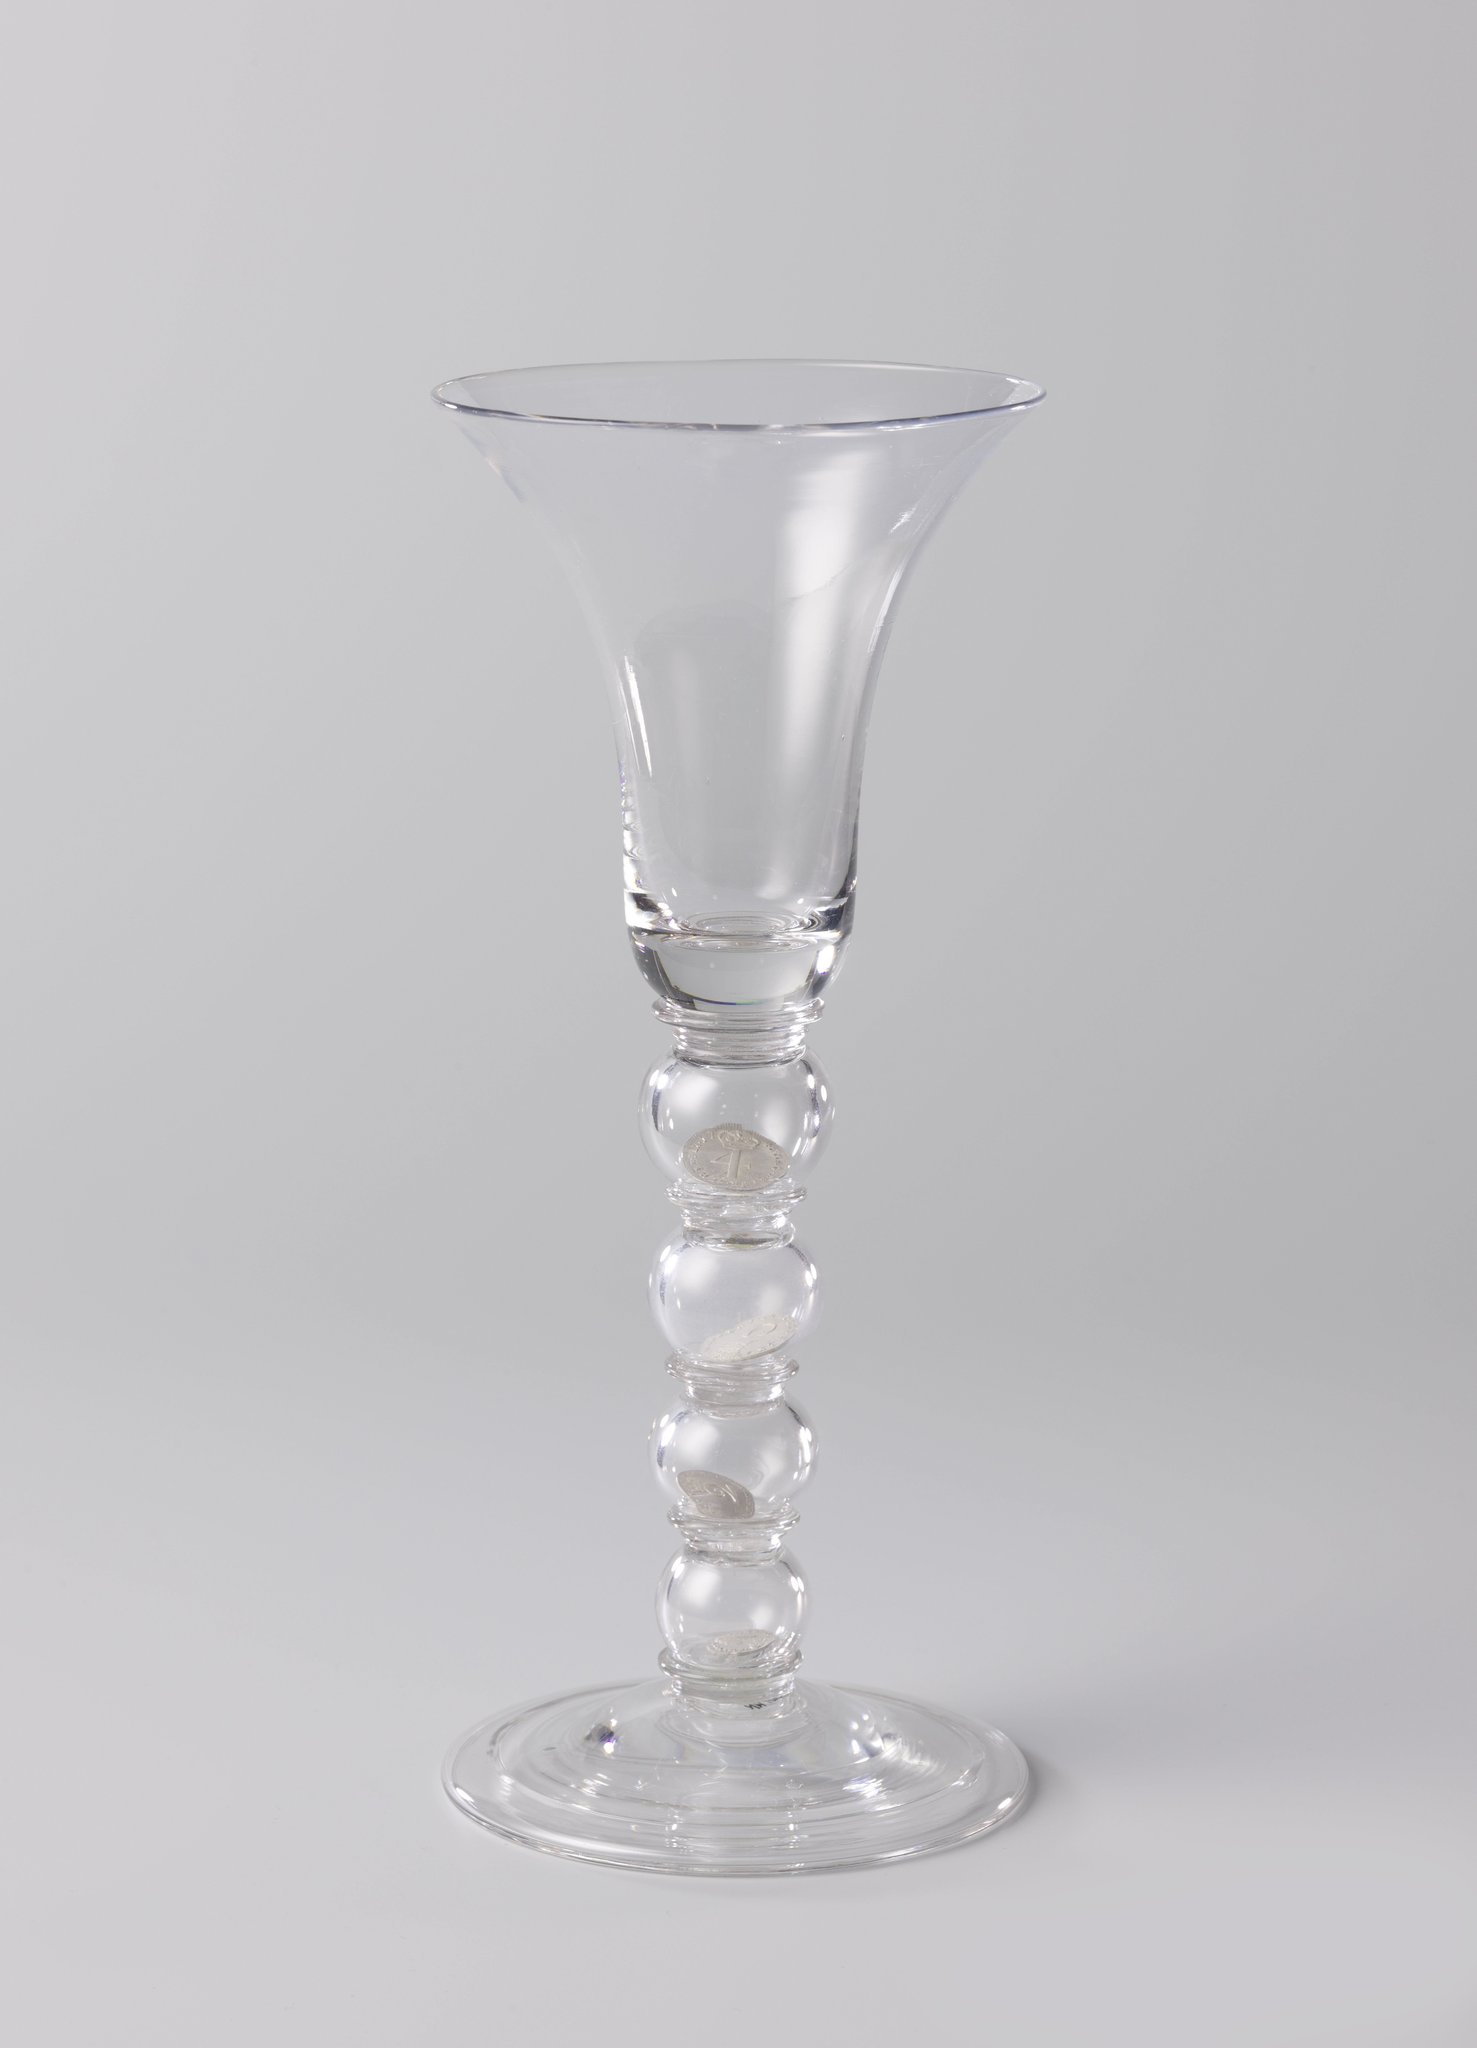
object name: goblet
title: drie pence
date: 1750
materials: glass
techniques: glassblowing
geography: england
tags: london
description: Kelkglas op licht gewelfde voet met omgeslagen rand. Stam opgebouwd uit vier holle nodi, gescheiden door schijven. Ingesloten in de nodi zijn zilveren munten van George II uit de jaren 1739 (penny), 1746 (twee pence), 1740 (drie pence) en 1746 (vier pence). Klokvormige kelk.